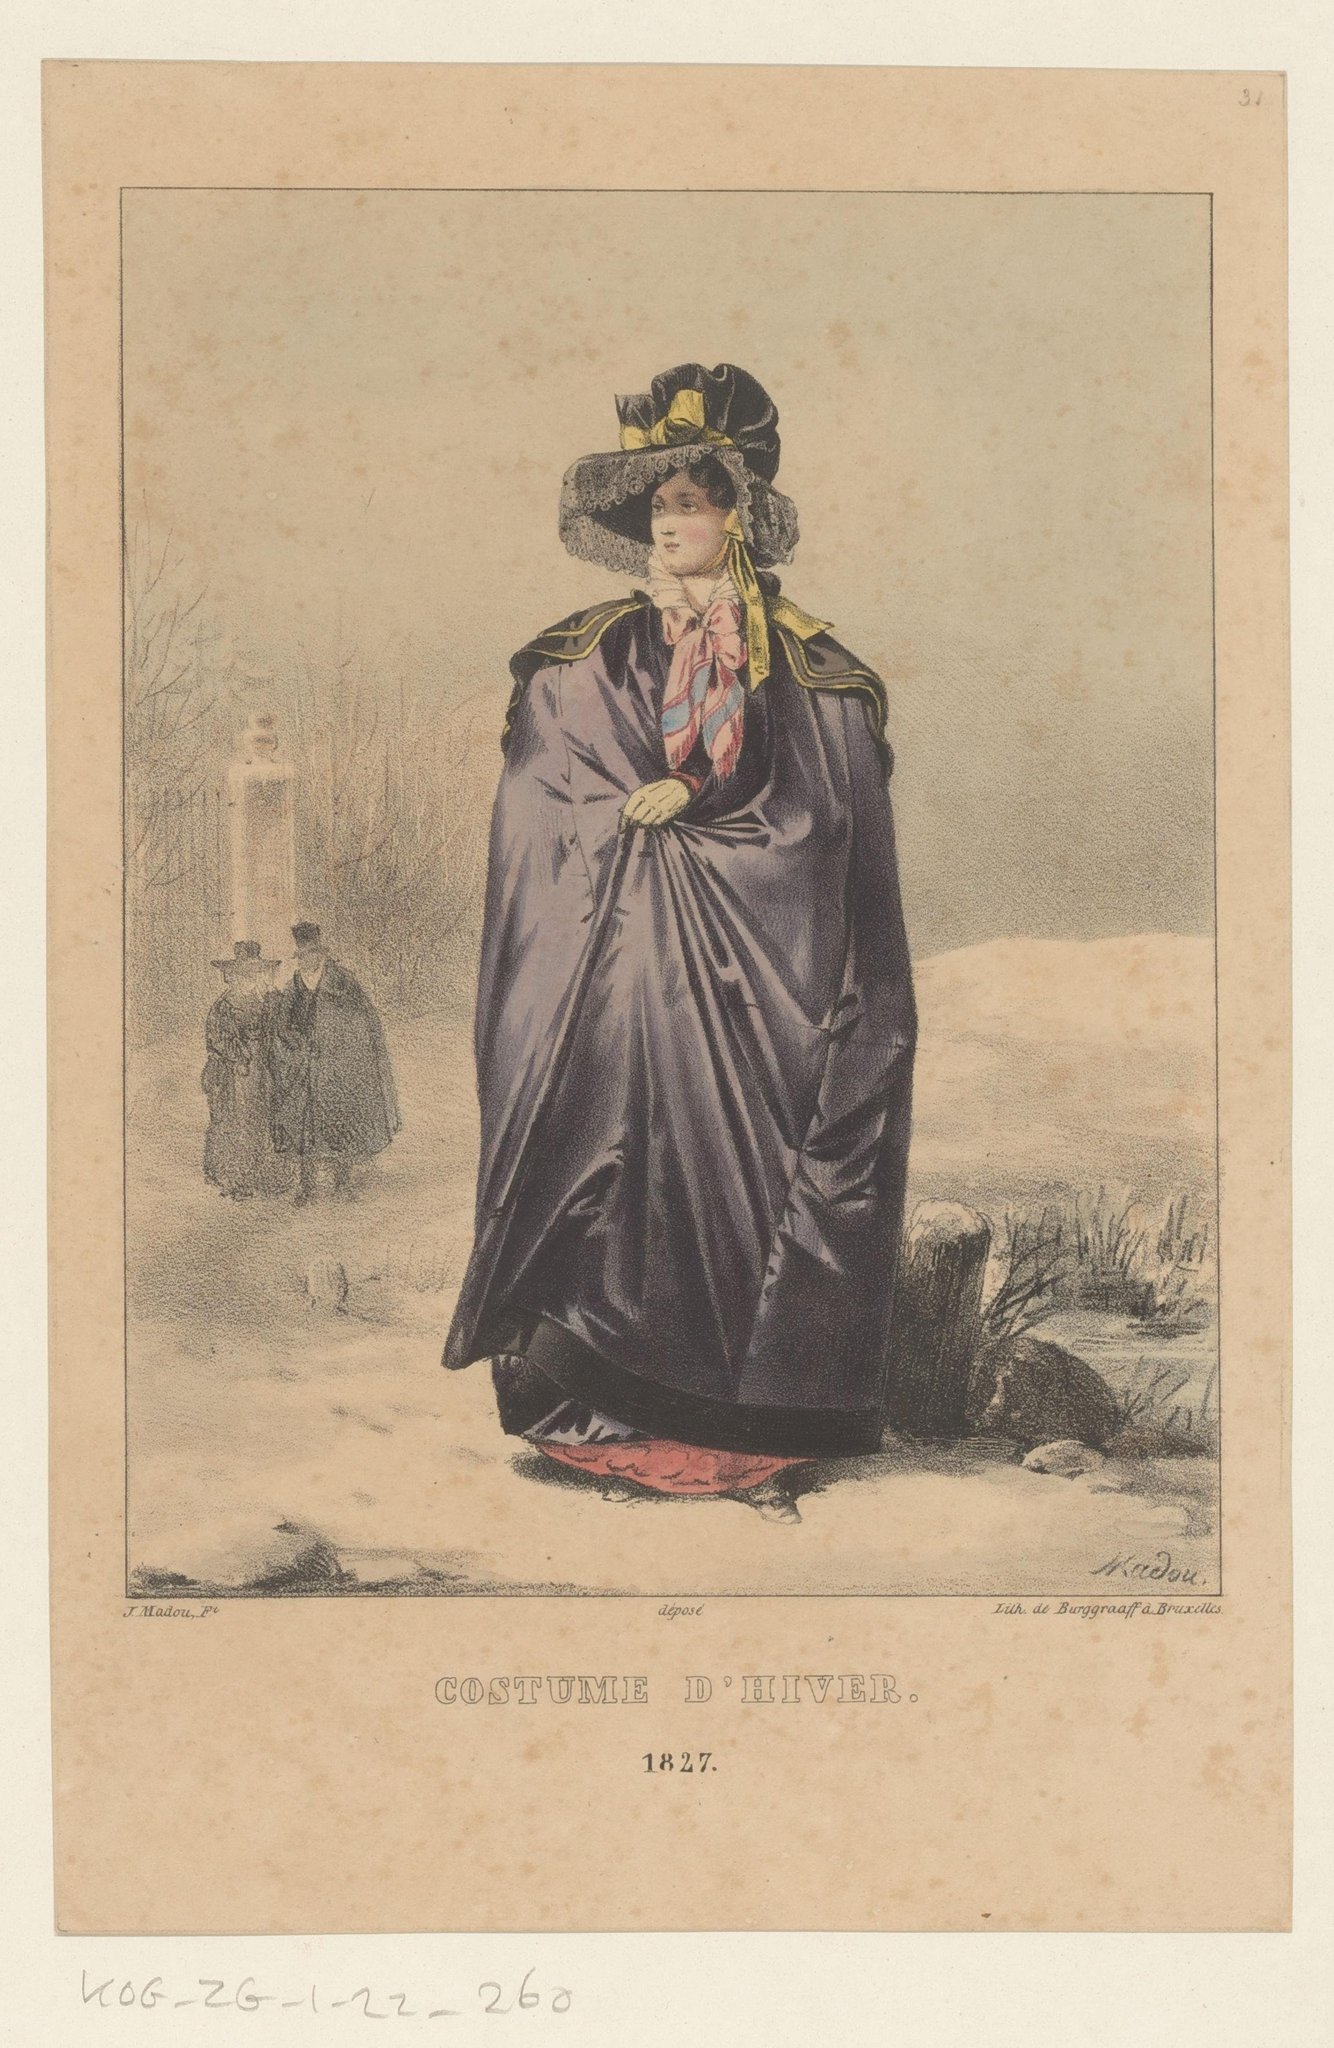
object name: print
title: Costume d'Hiver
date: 1835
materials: paper, watercolor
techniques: hand coloring, lithograph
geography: belgium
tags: coat, clothes, costume (+ women's clothes), snow, folk costume, regional costume, southern netherlands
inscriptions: collector's mark, collector's mark: Lugt 1641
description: Van den Burggraaff wilde een serie (twintig afleveringen met telkens vier platen) uitgeven met kostuums uit alle provincies van Nederland en België onder de titel 'Costumes du peuple de toutes les provinces des Pays-Bas'. Hij begint met deze serie in 1825 en eindigt hiermee bij de dertiende aflevering in 1830. Omdat in 1830 België zich afsplitst van Nederland geeft hij de prenten daarna apart uit onder de titels 'Costumes de peuple Hollandais' en 'Collection de costumes du peuple des provinces de la Belgique' (1835).